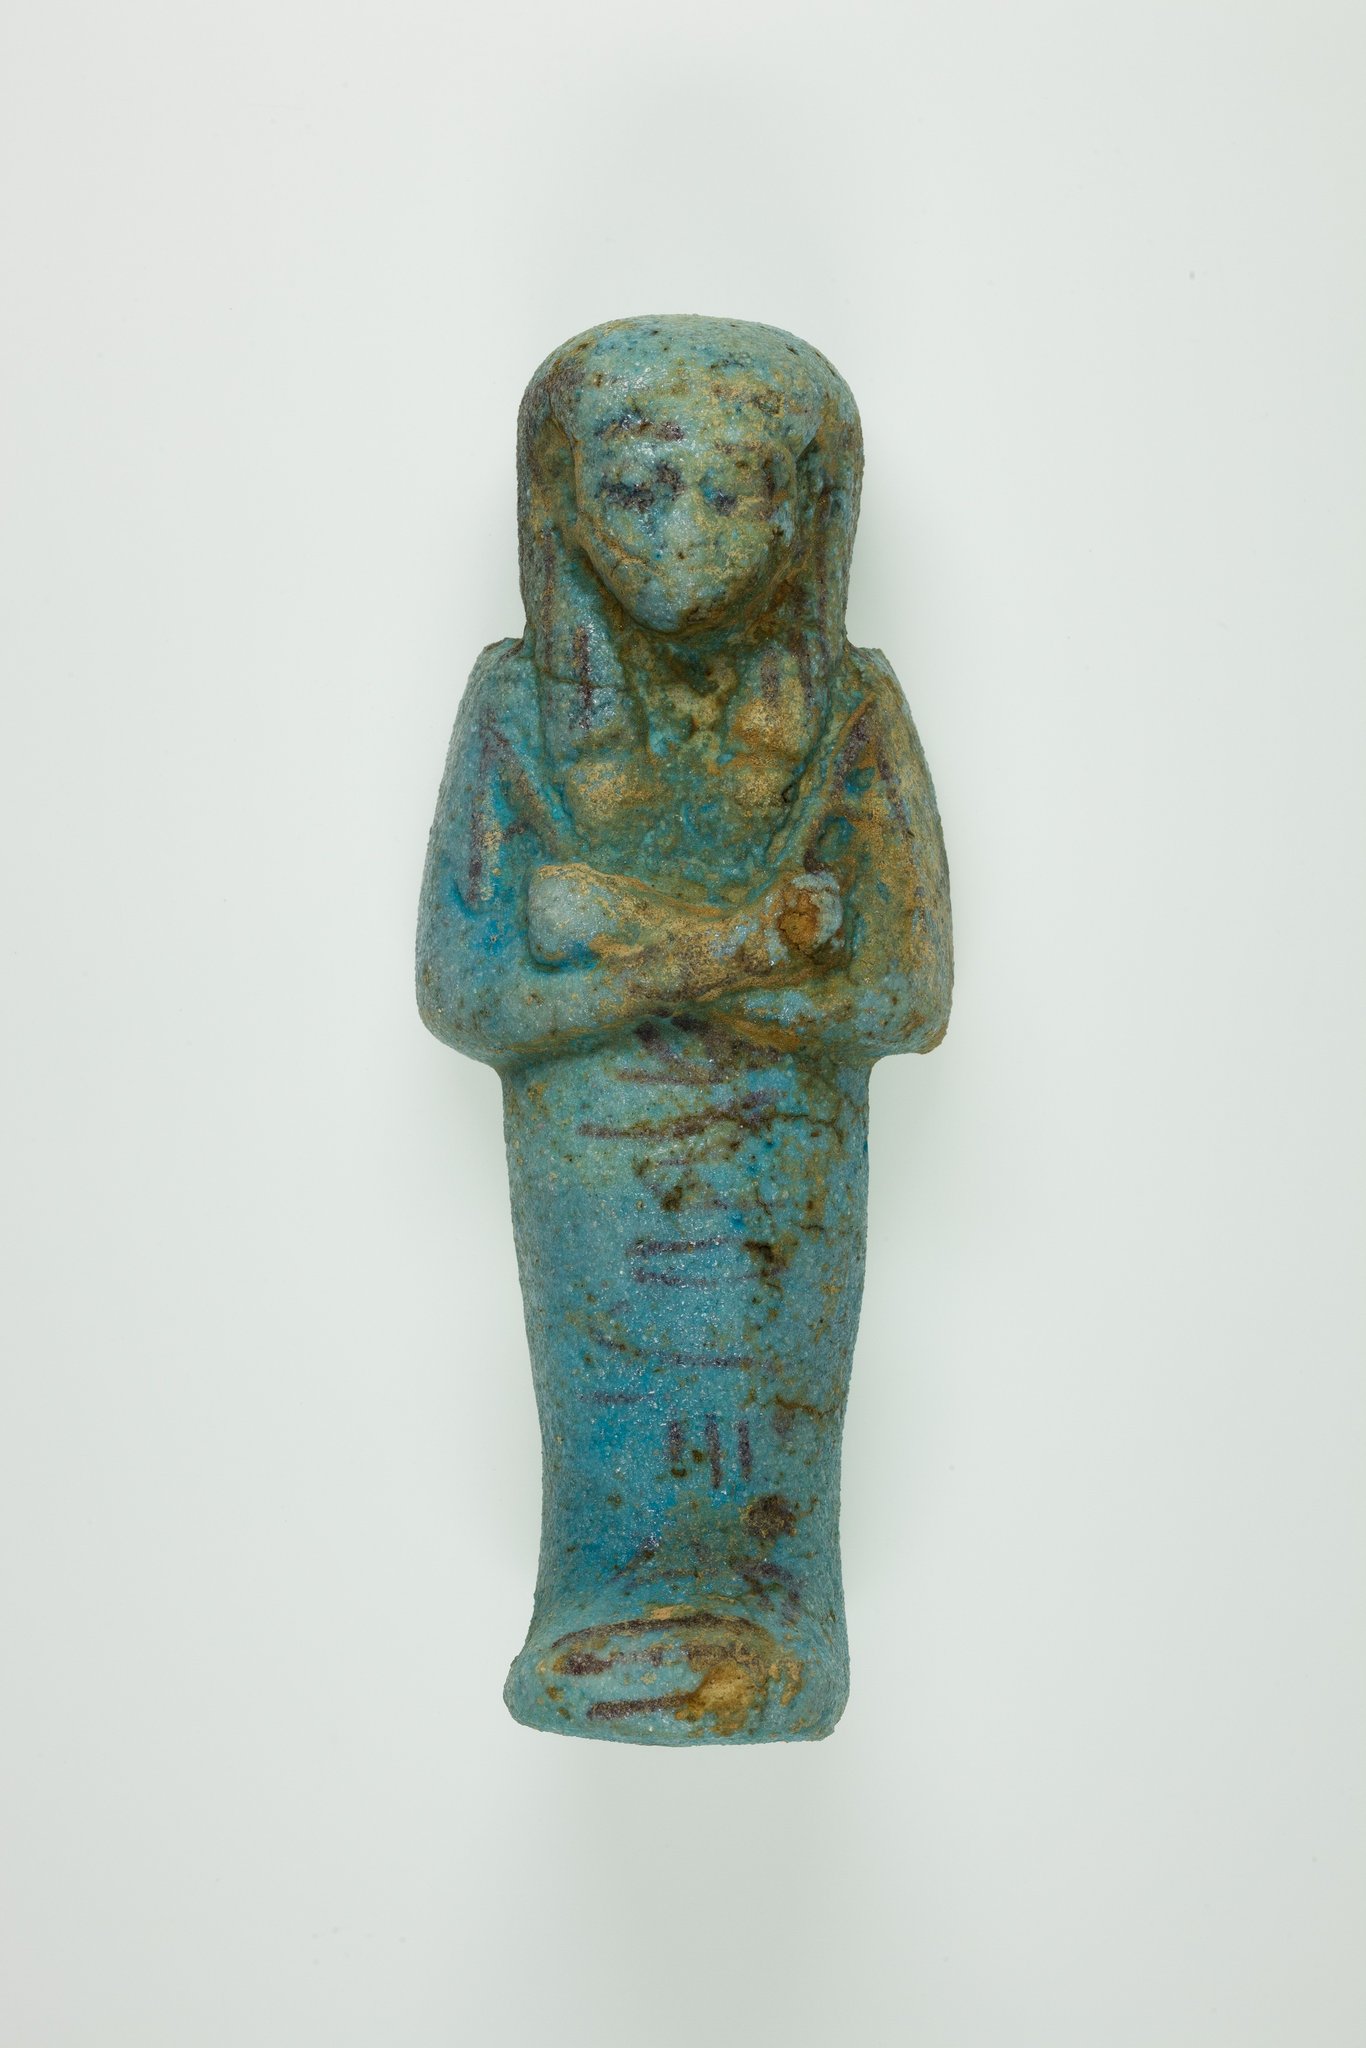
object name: worker shabti, henettawy c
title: Worker Shabti of Henettawy (C), Daughter of Isetemkheb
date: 990-970 BCE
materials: faience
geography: egypt